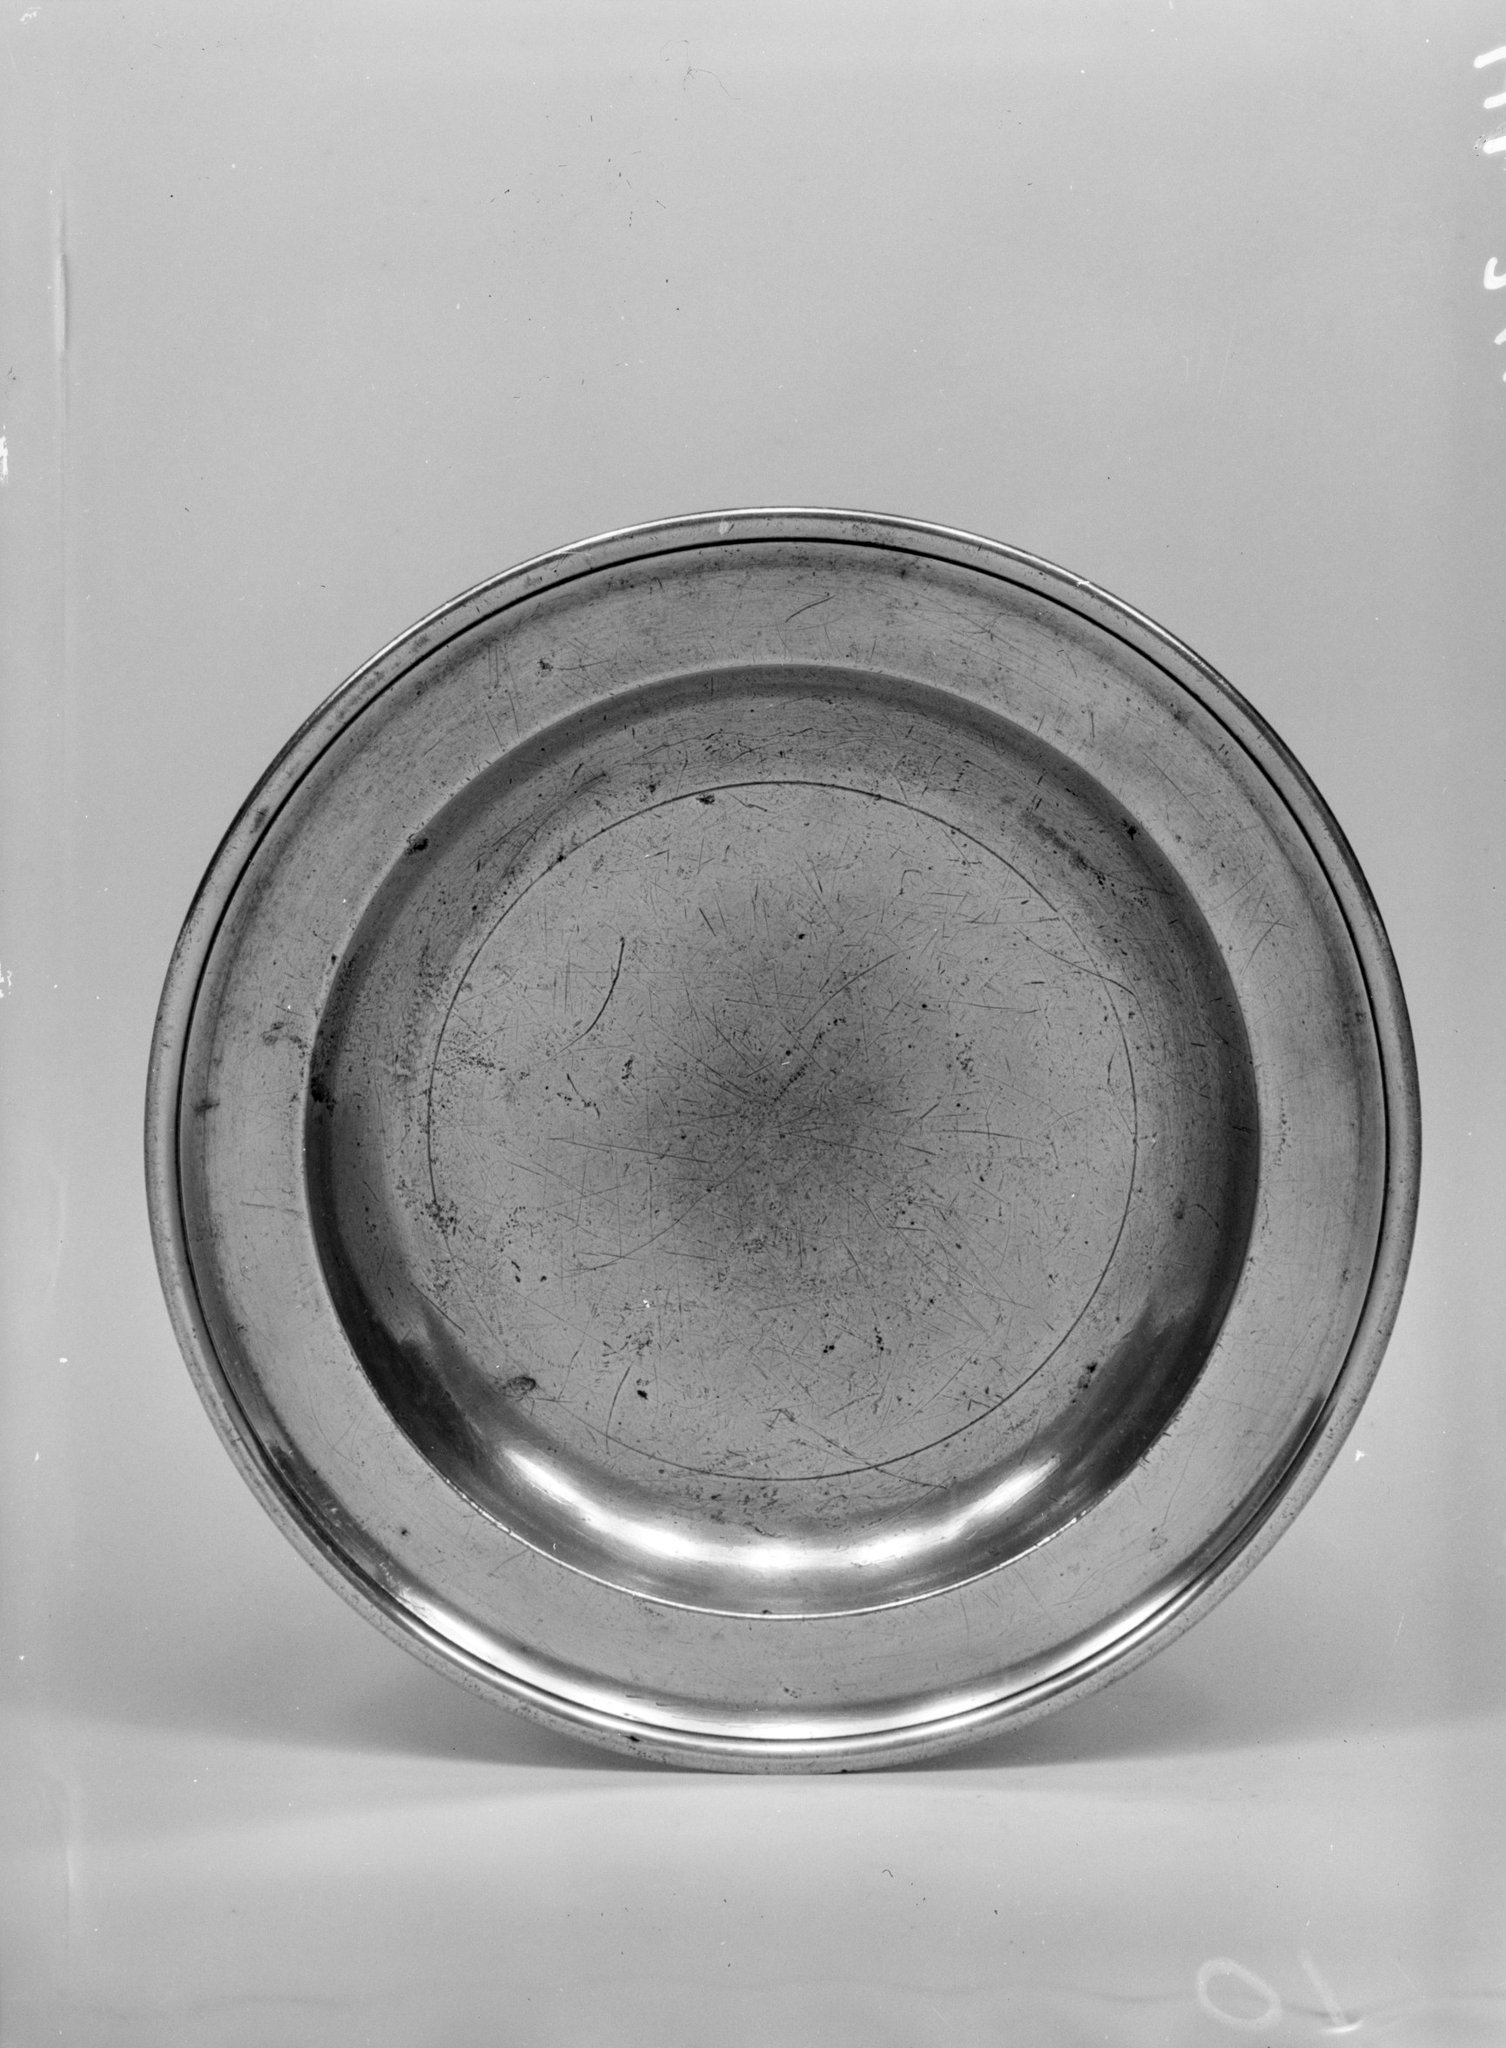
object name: plate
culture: american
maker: francis bassett, i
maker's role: maker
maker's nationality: american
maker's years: 1690-1758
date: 1718-1799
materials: pewter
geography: united states